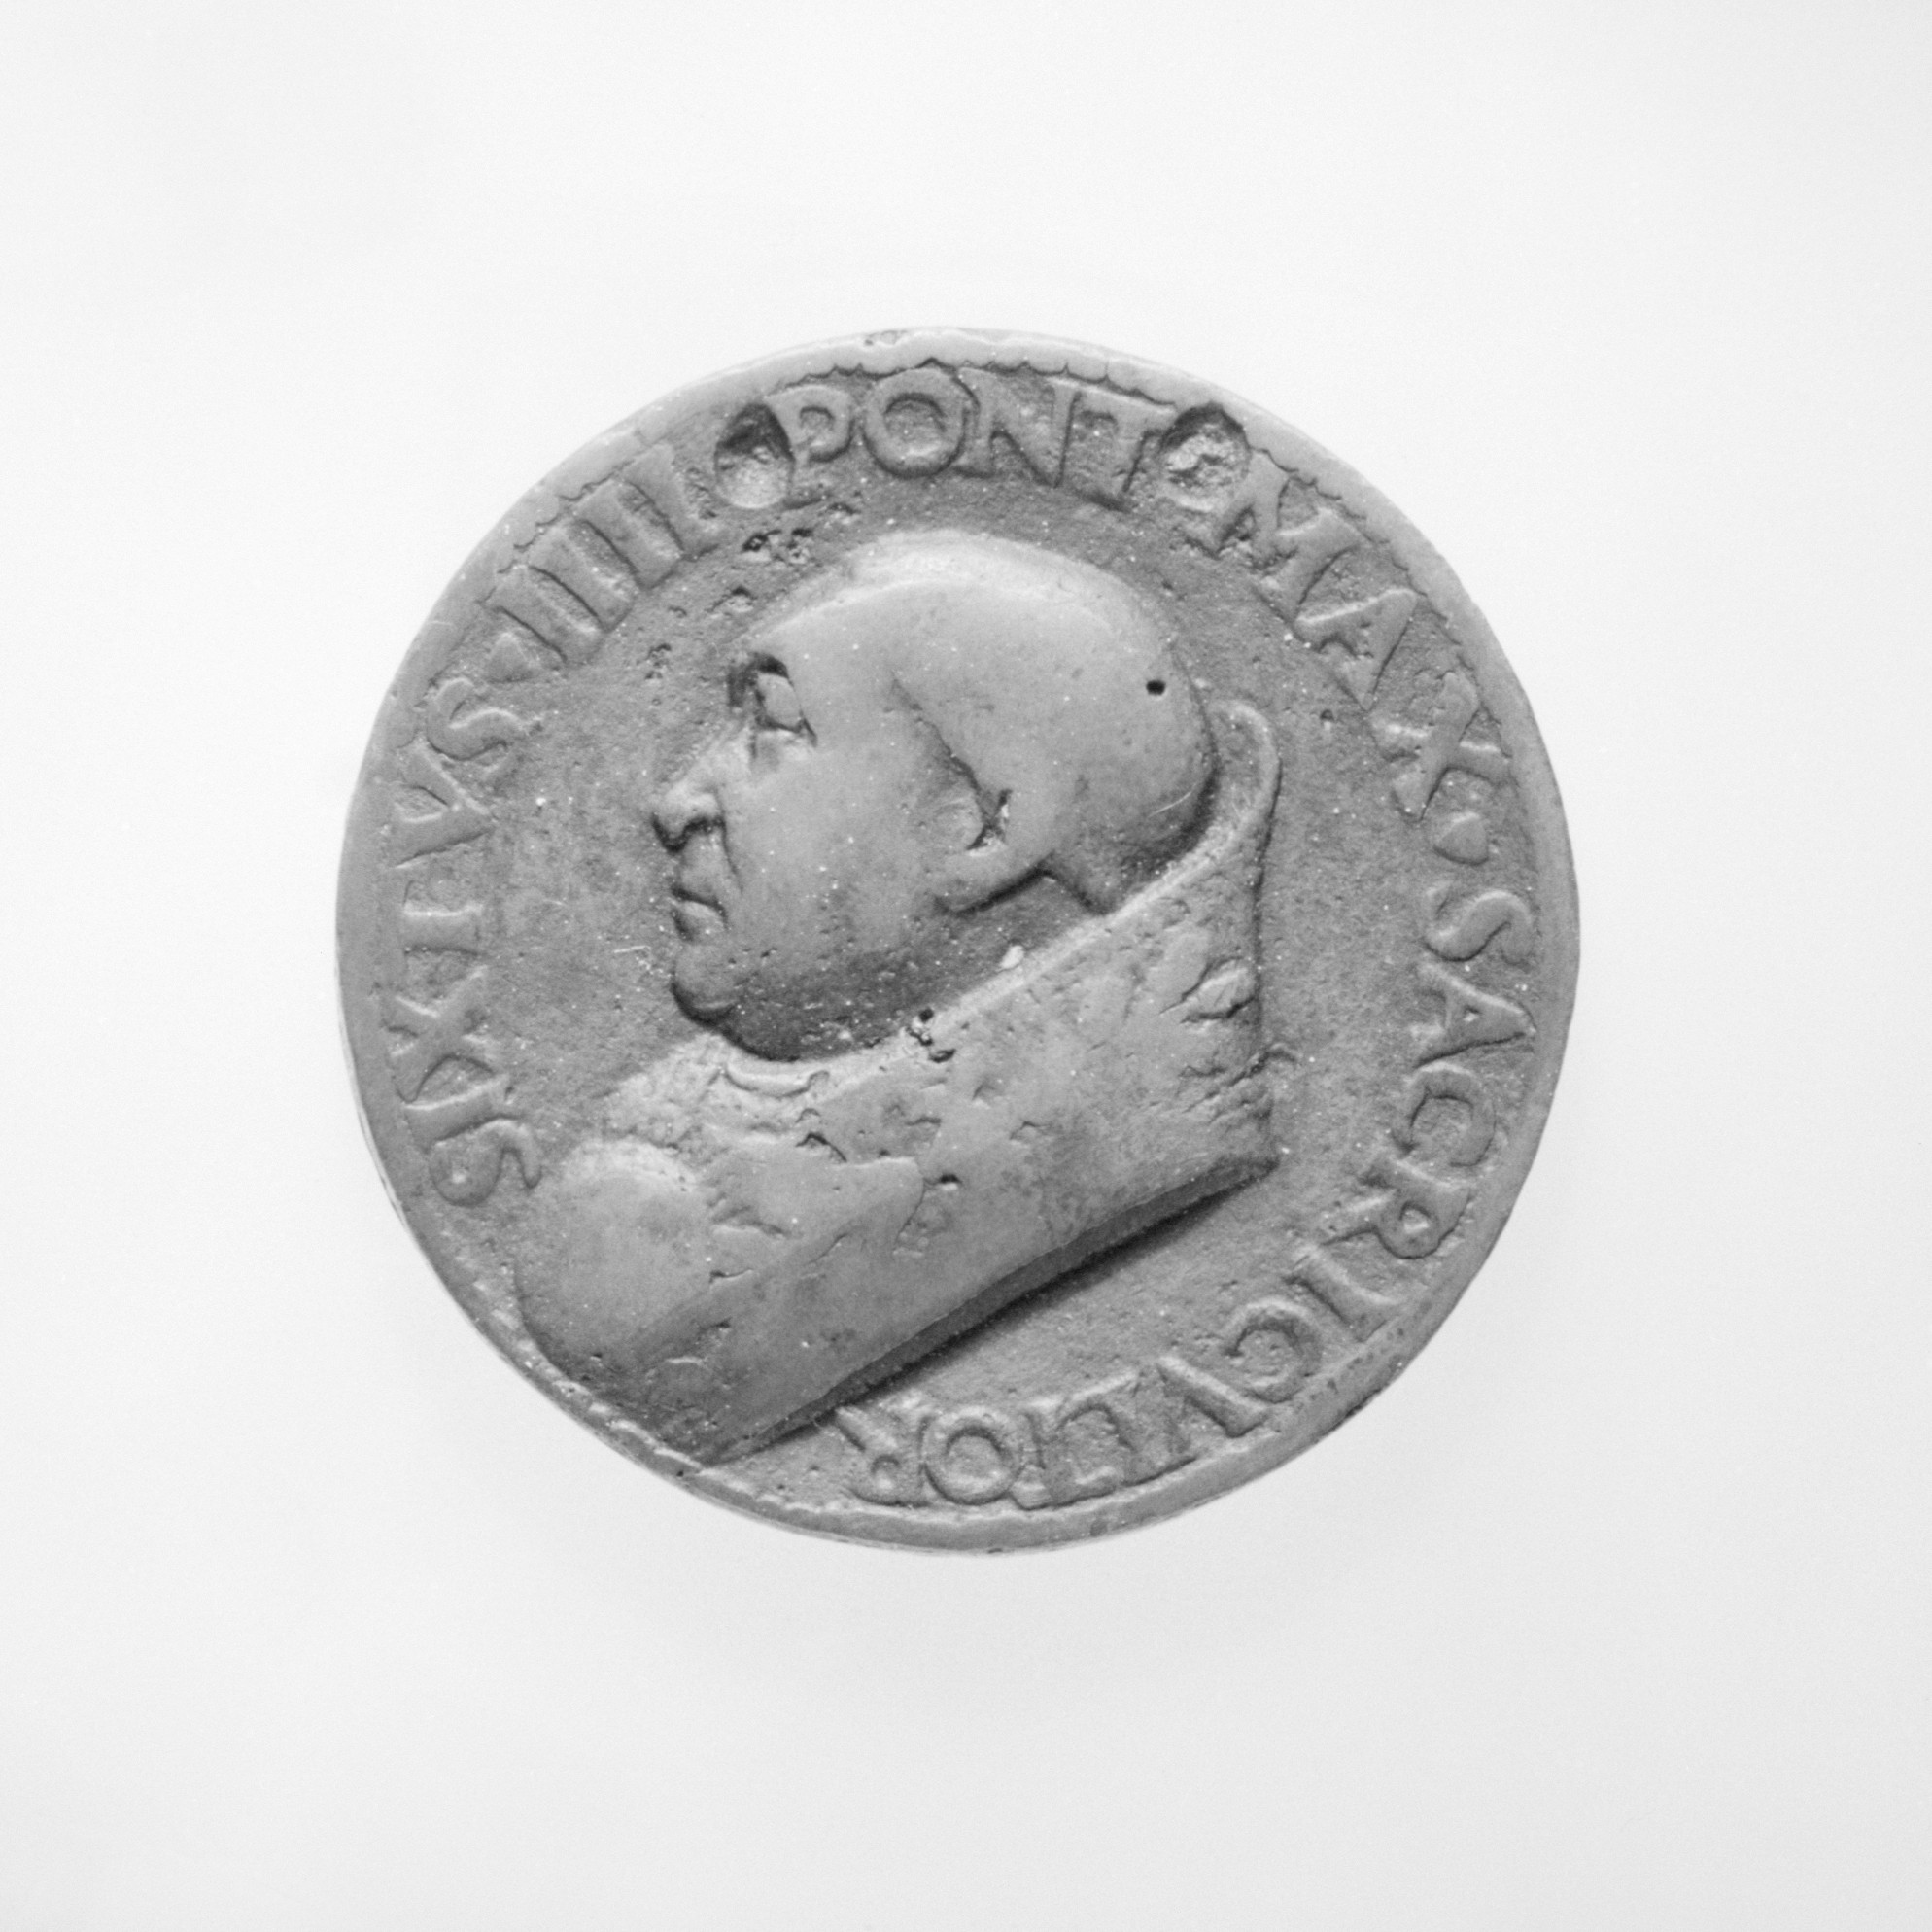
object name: medal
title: Pope Sixtus IV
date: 1401-1500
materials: bronze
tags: men,profiles